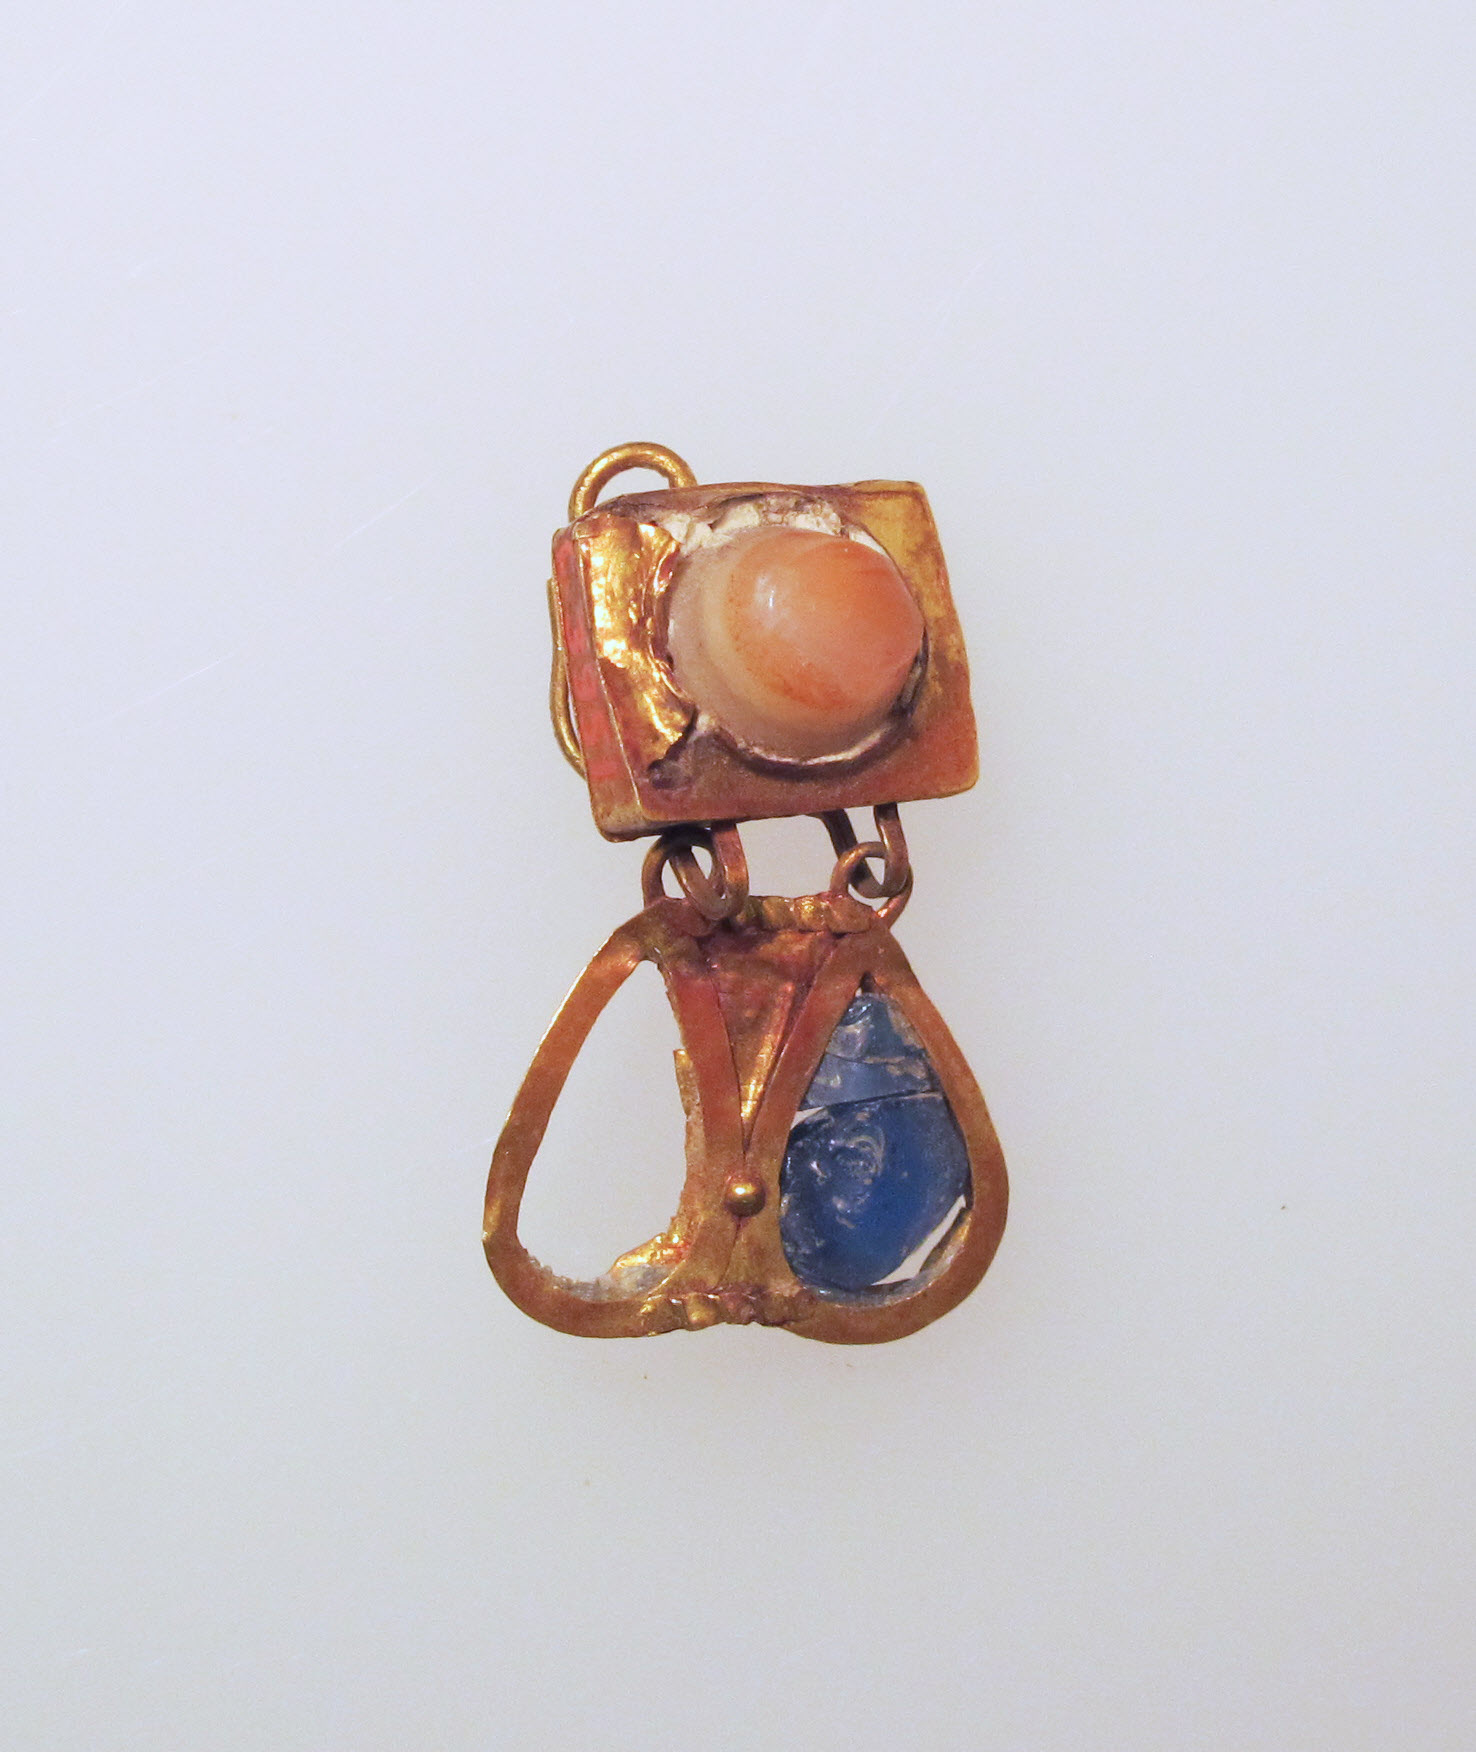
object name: earring hook type, with pendant and agate setting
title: Earring-hook type, with pendants and agate setting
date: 7000 BCE-330 CE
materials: stone, gold